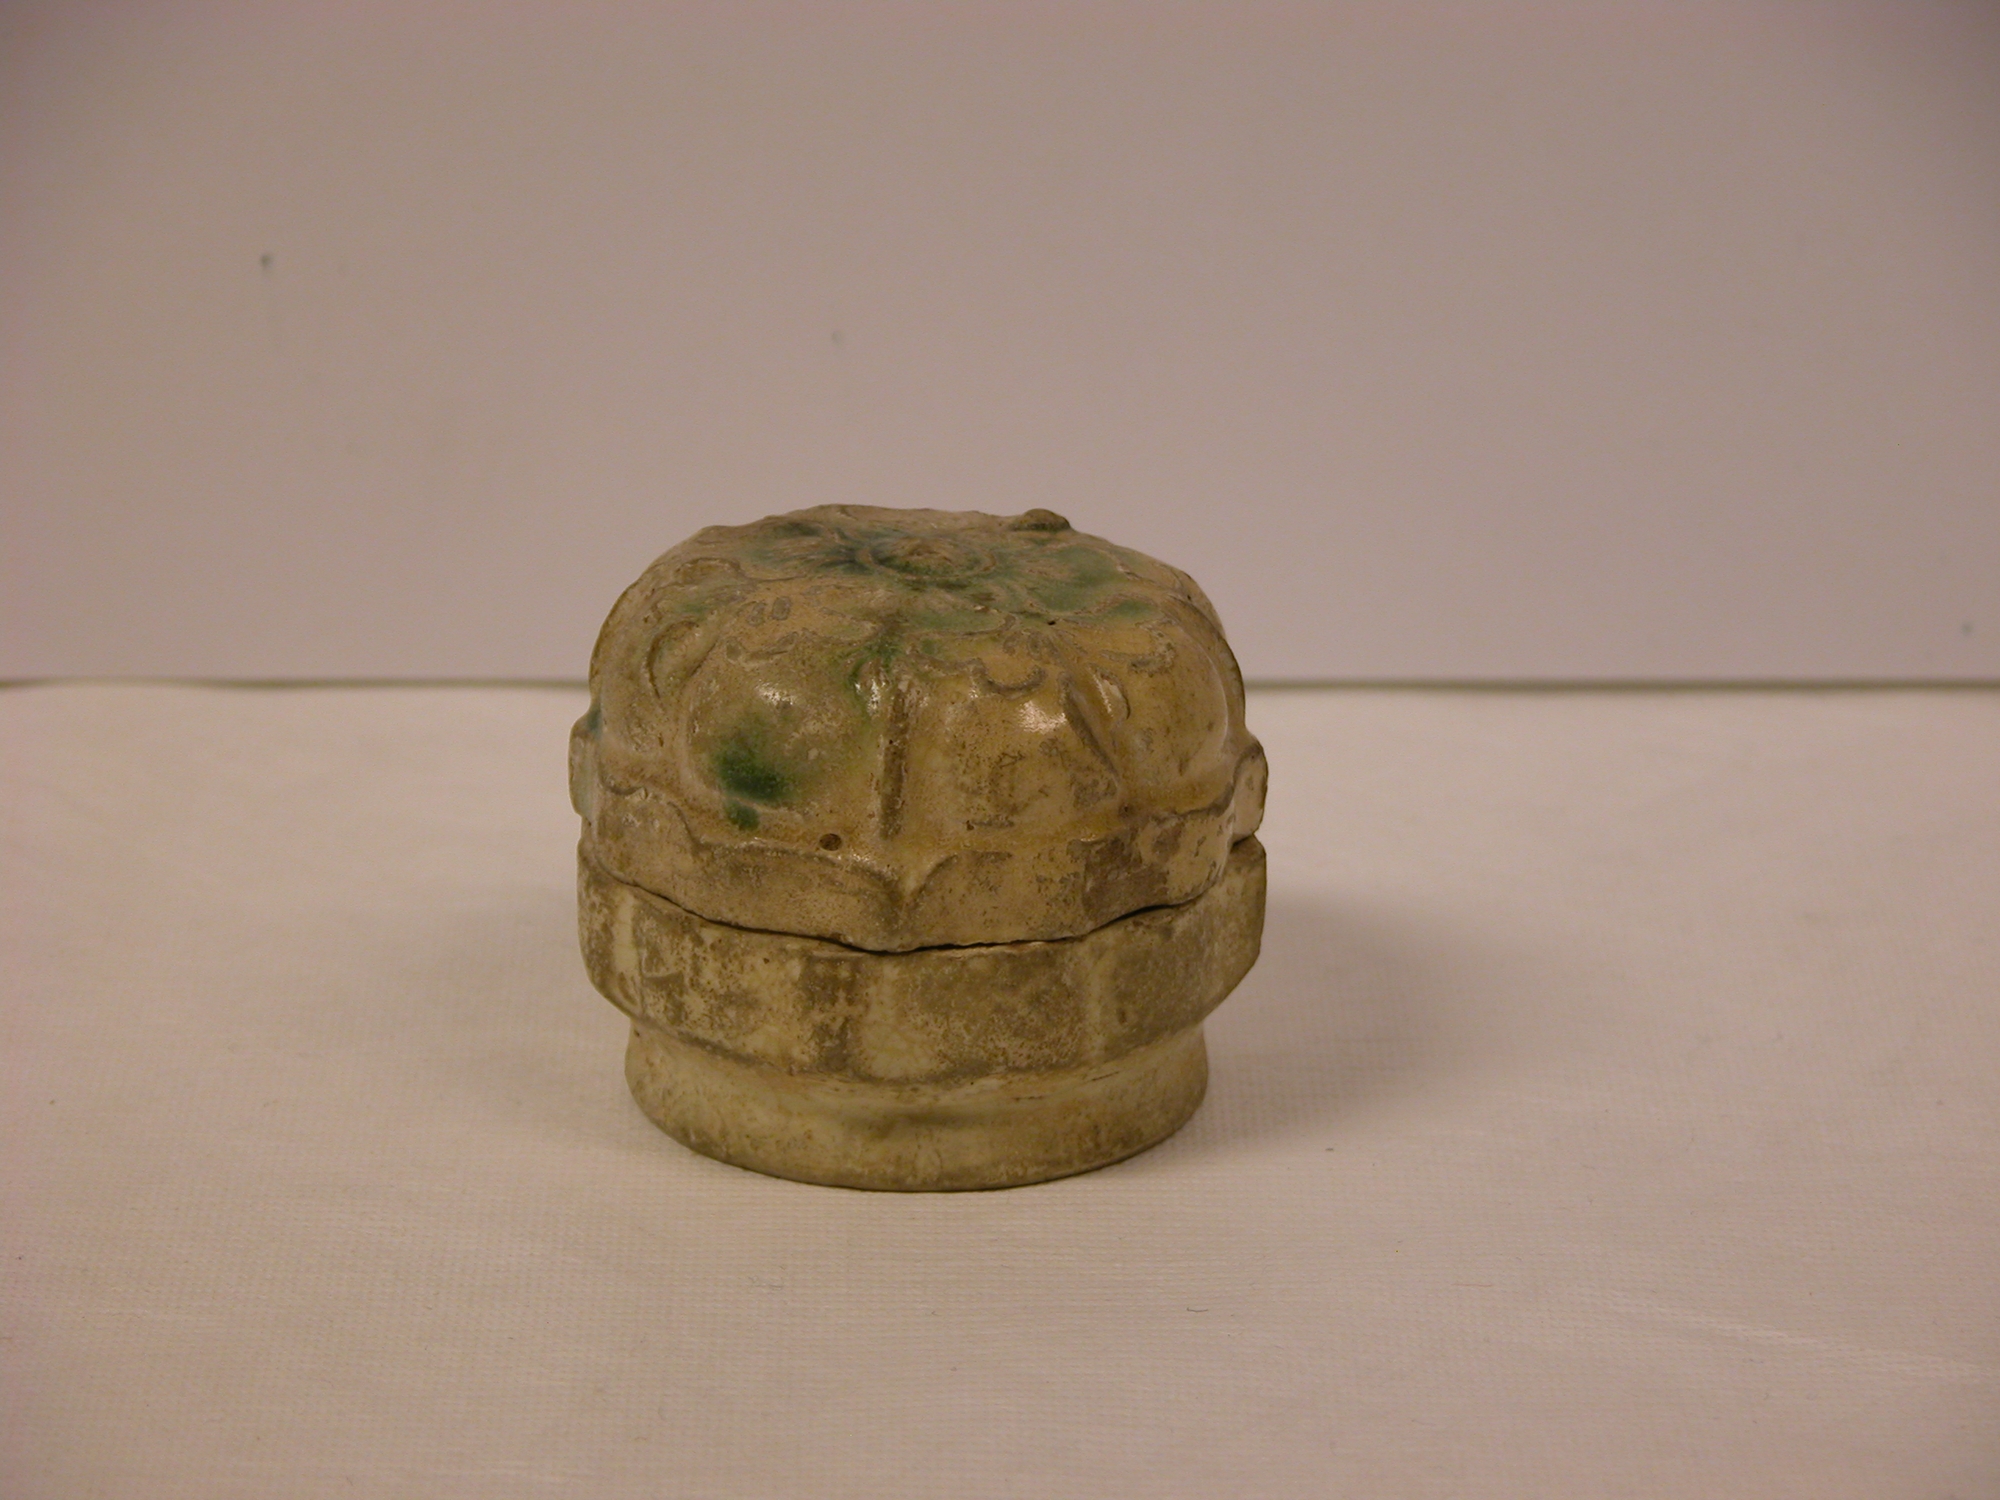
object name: box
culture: chinese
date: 618-907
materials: earthenware, glaze